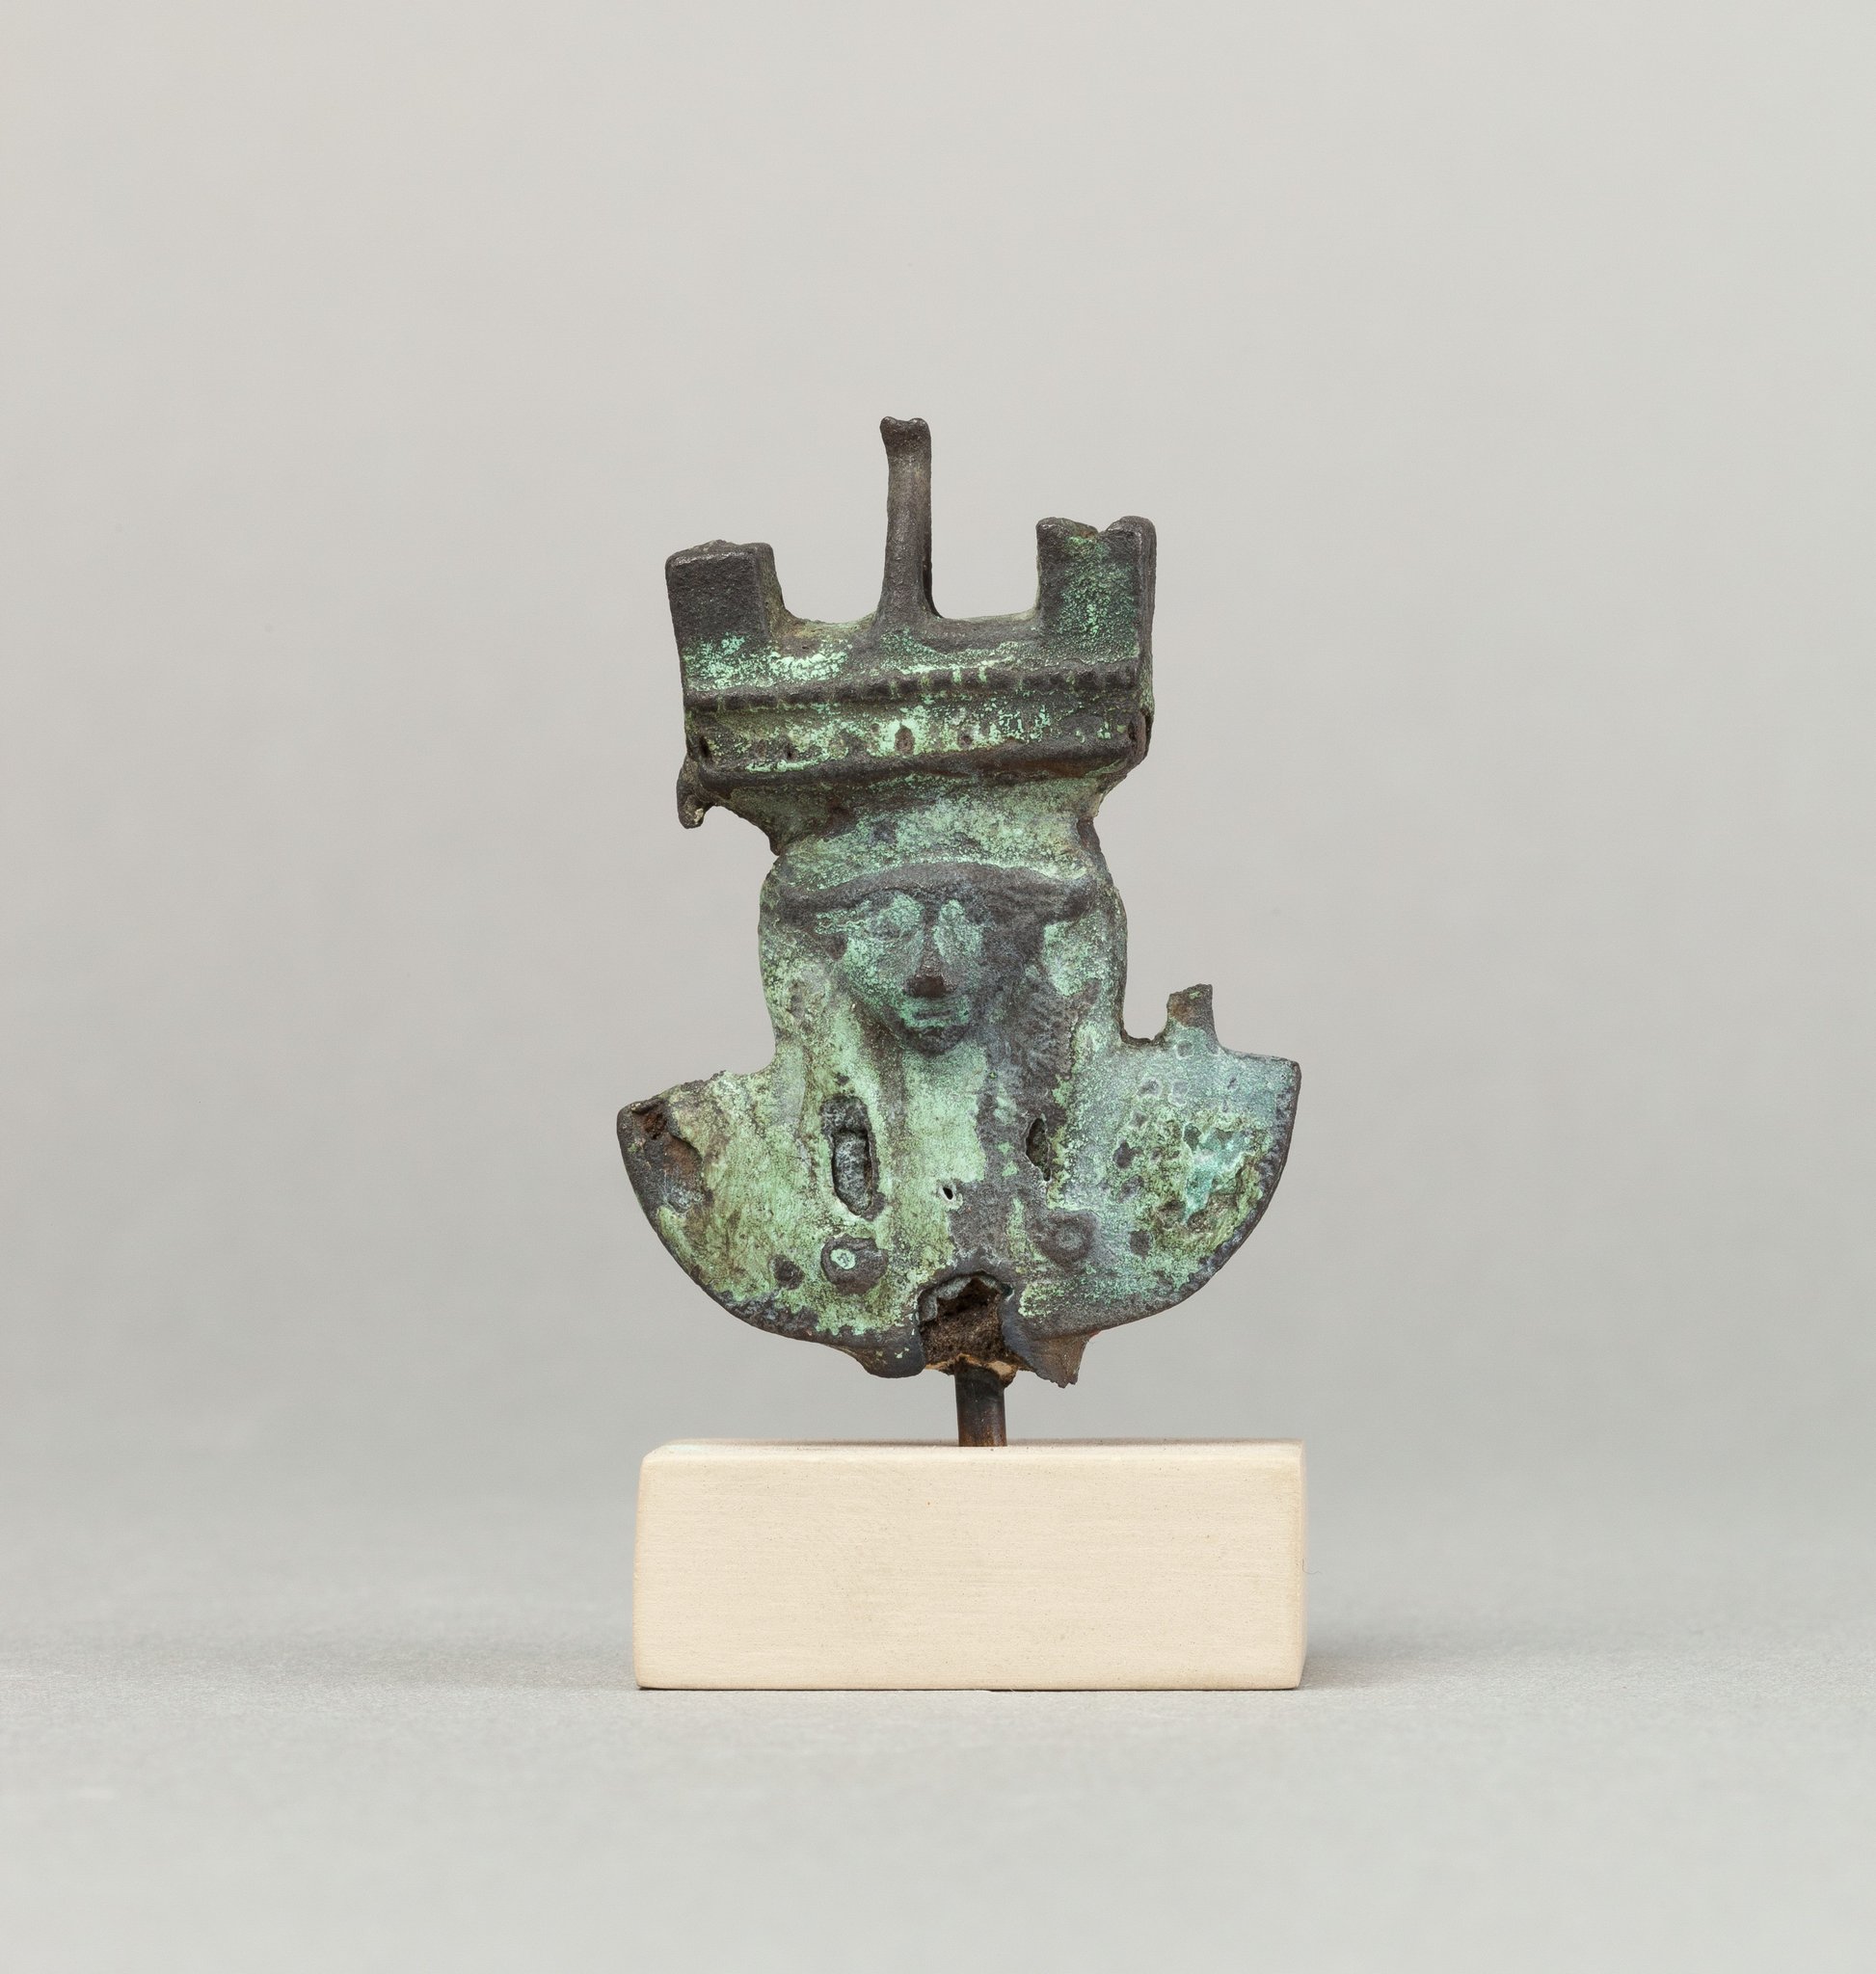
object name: music, sistrum, hathor emblem, bat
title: Hathor sistrum head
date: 664-630 BCE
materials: metal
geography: egypt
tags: hathor